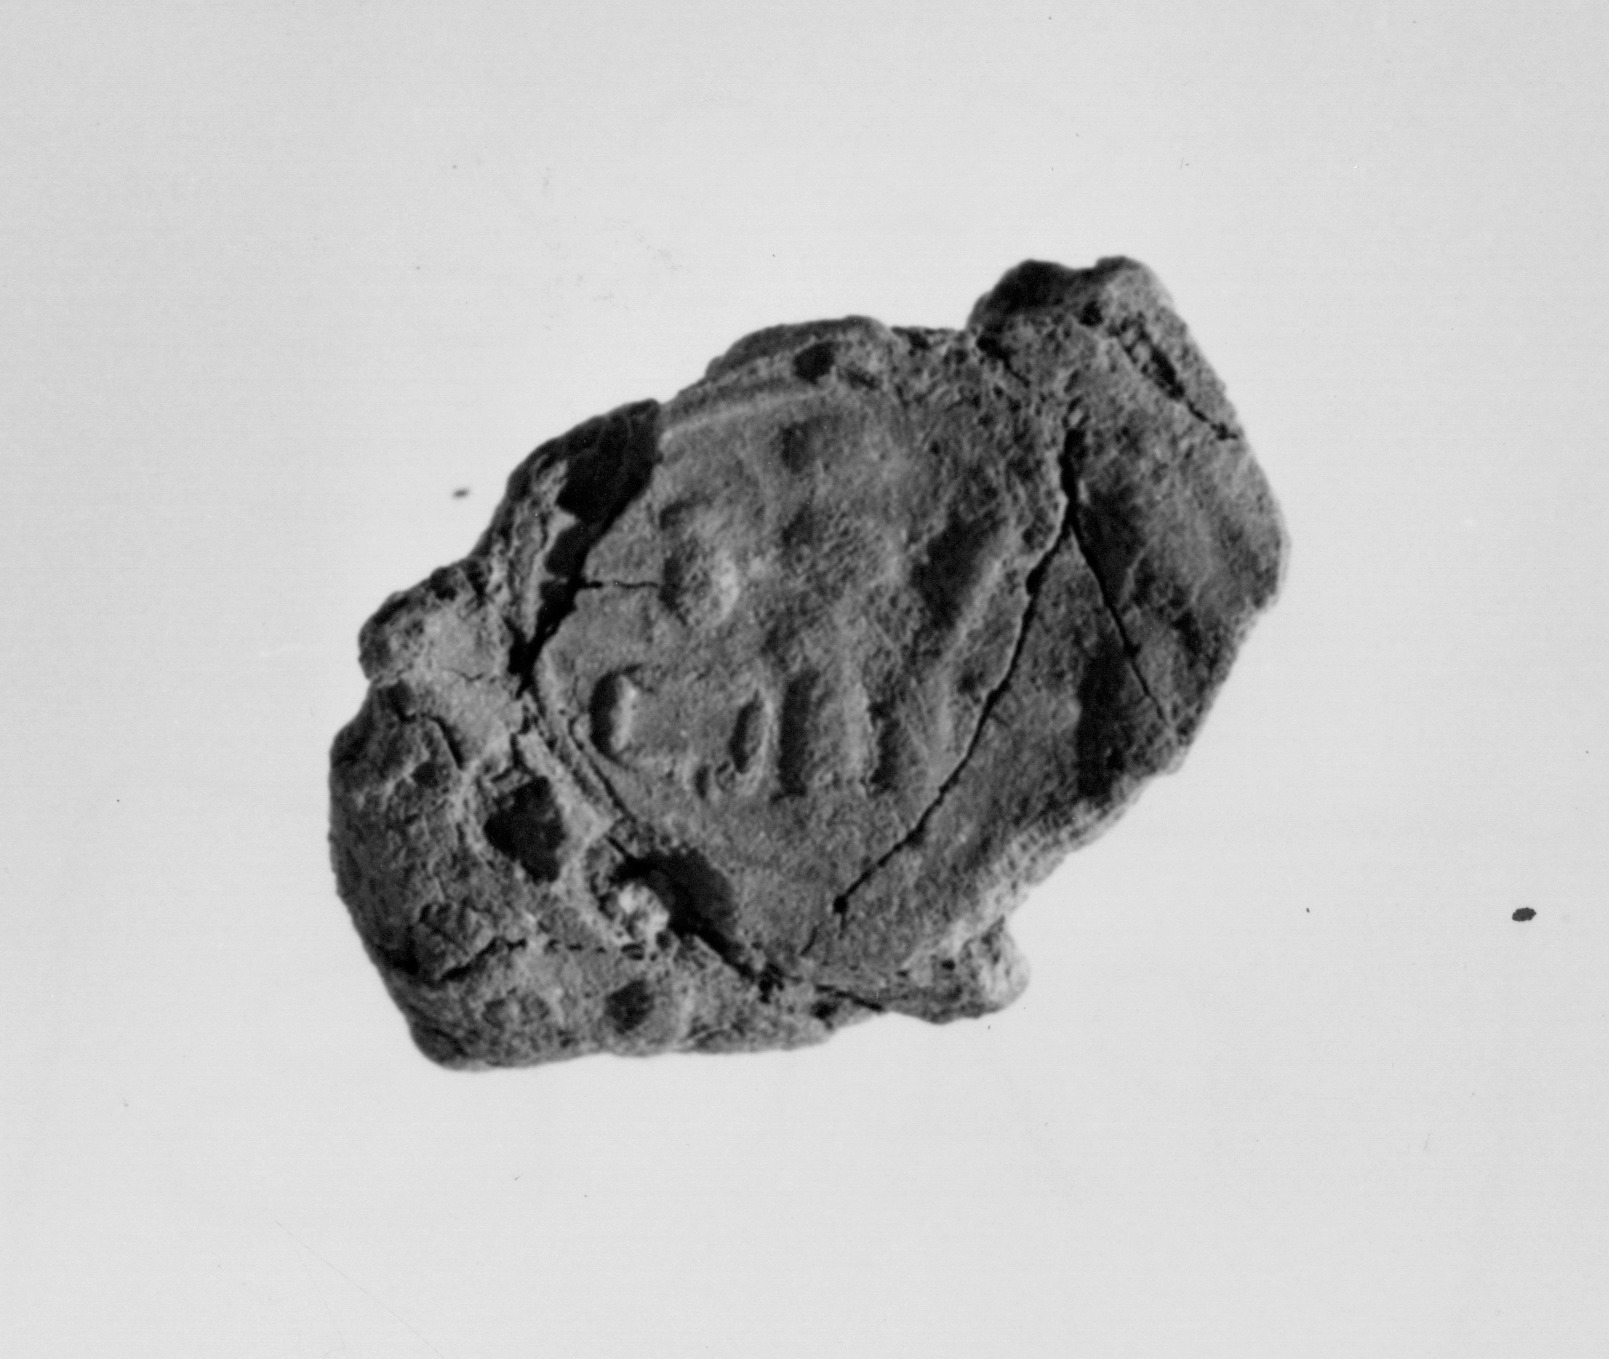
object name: sealing, lion, per kheper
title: Document Sealing With the Throne Name of Amenhotep III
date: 1390-1352 BCE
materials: mud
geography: egypt